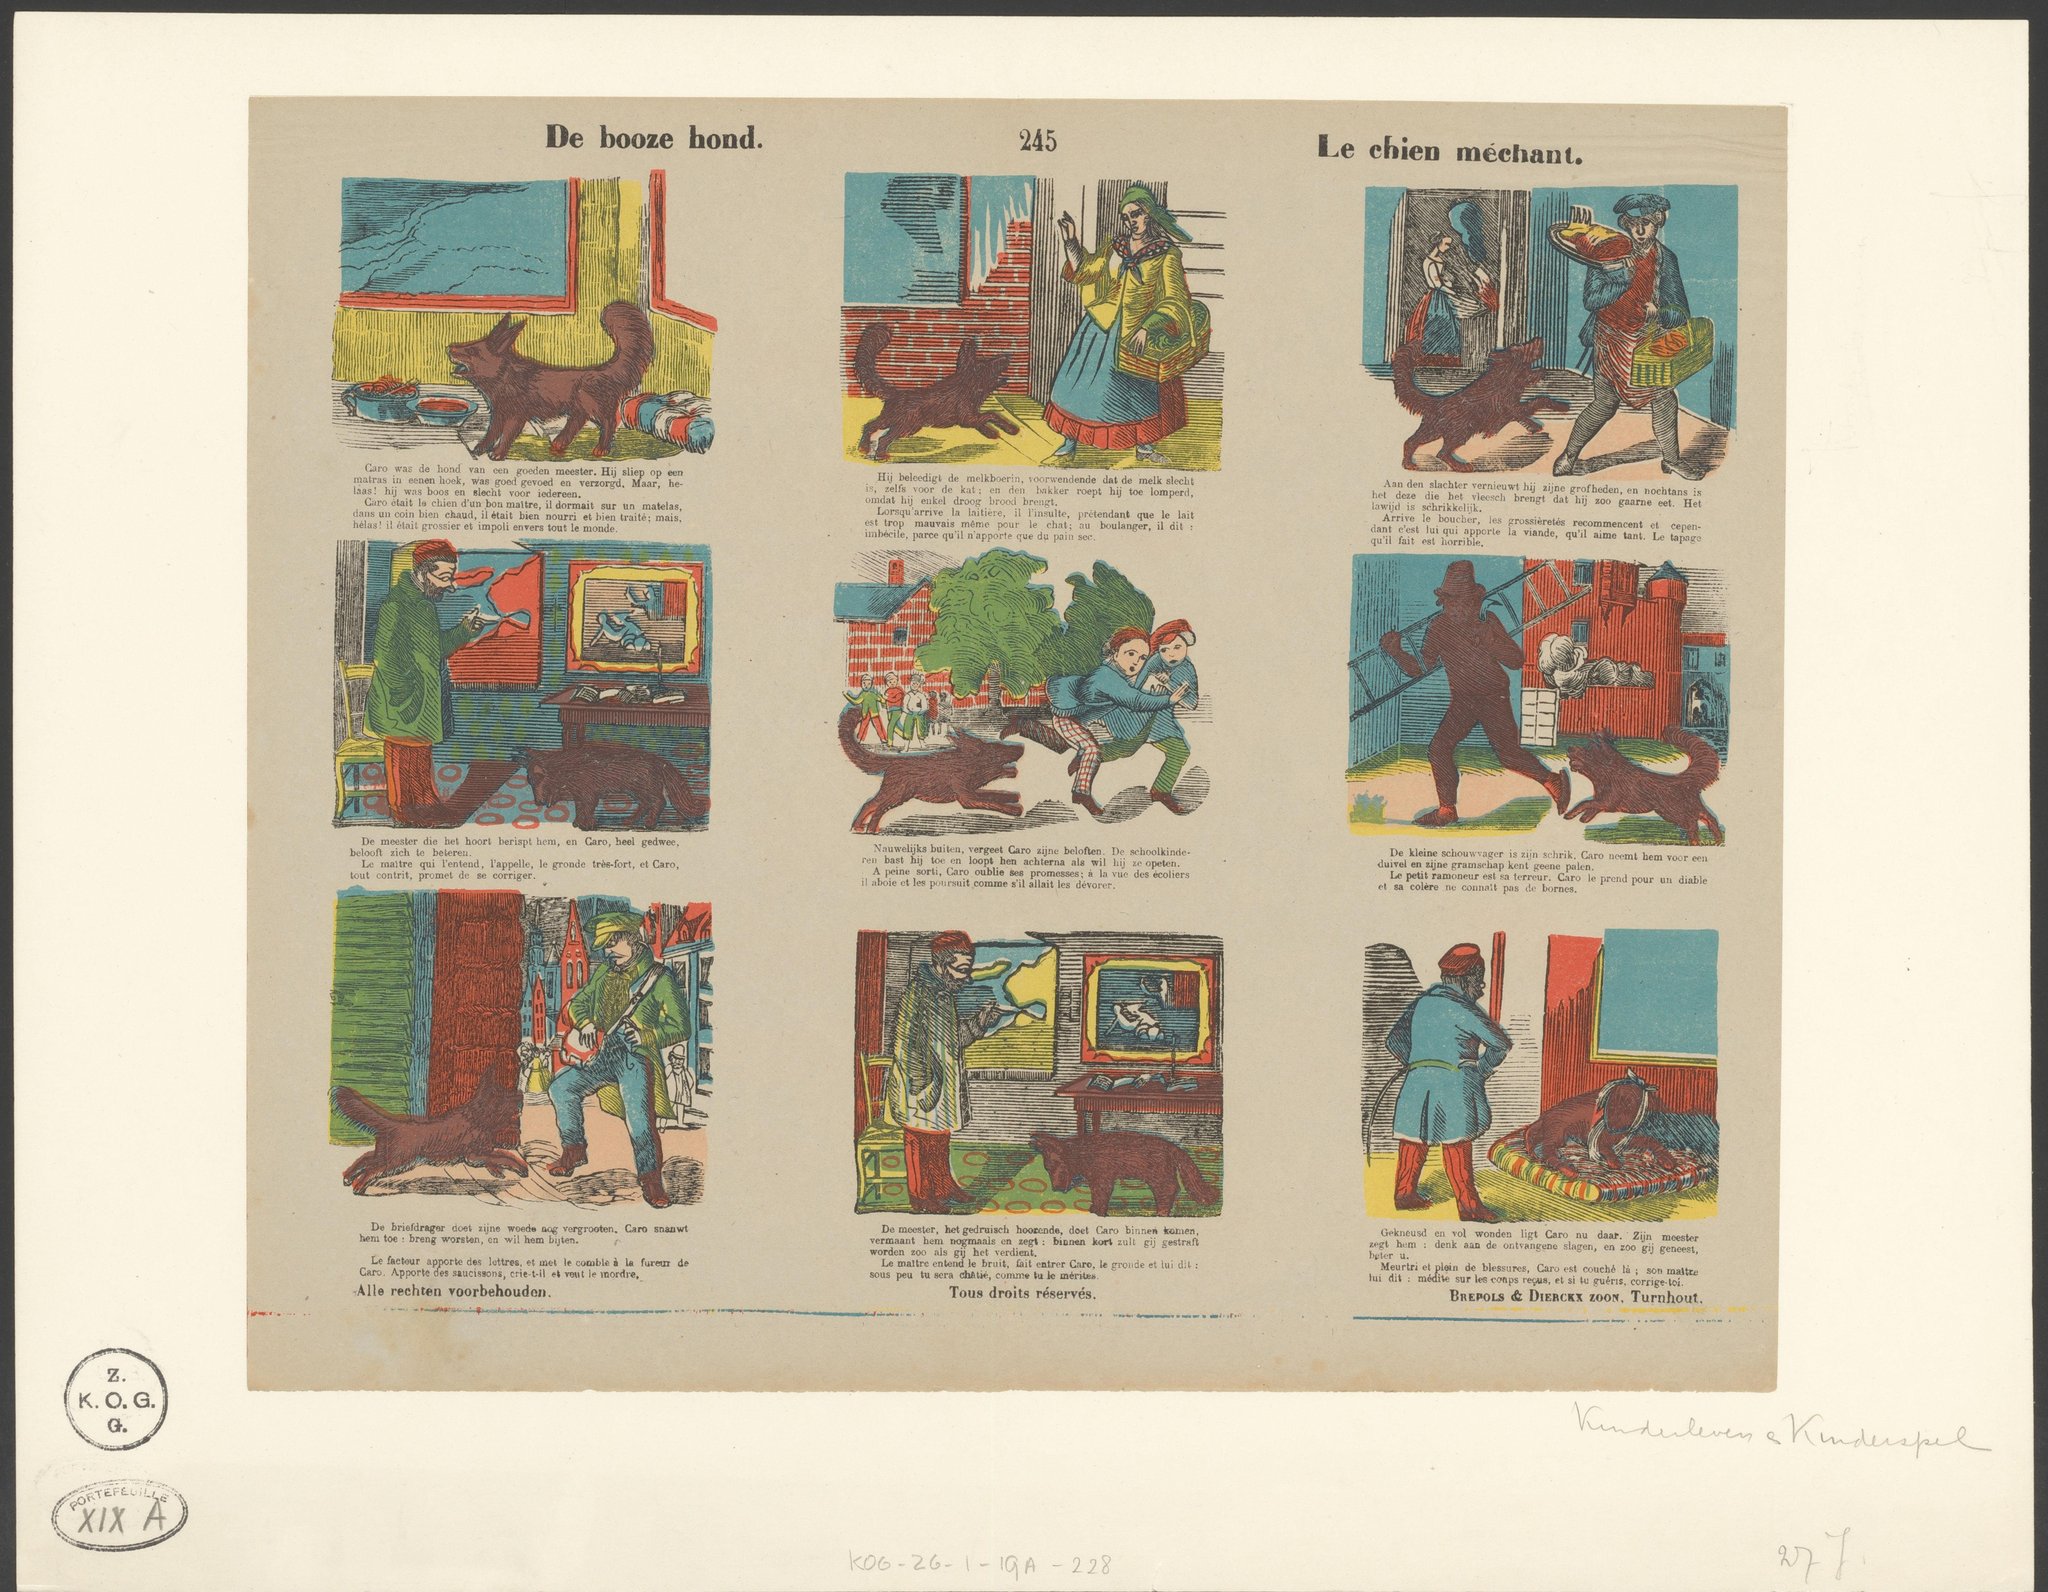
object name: print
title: Boze hond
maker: Anonymous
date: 1833-1911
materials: paper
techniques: lithograph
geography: turnhout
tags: bad behaviour, dog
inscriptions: collector's mark: Lugt 1641, stamp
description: Onderaan een tekst in het Nederlands en Frans. Bovenaan genummerd: 245. Onderwerpsrubrieken binnen de Atlas Zeden en Gewoonten: Zeden en Gewoonten in Engeren Zin, Des menschen beging, midden en einde, Kinderleven – Kinderspel en Kinderprenten.